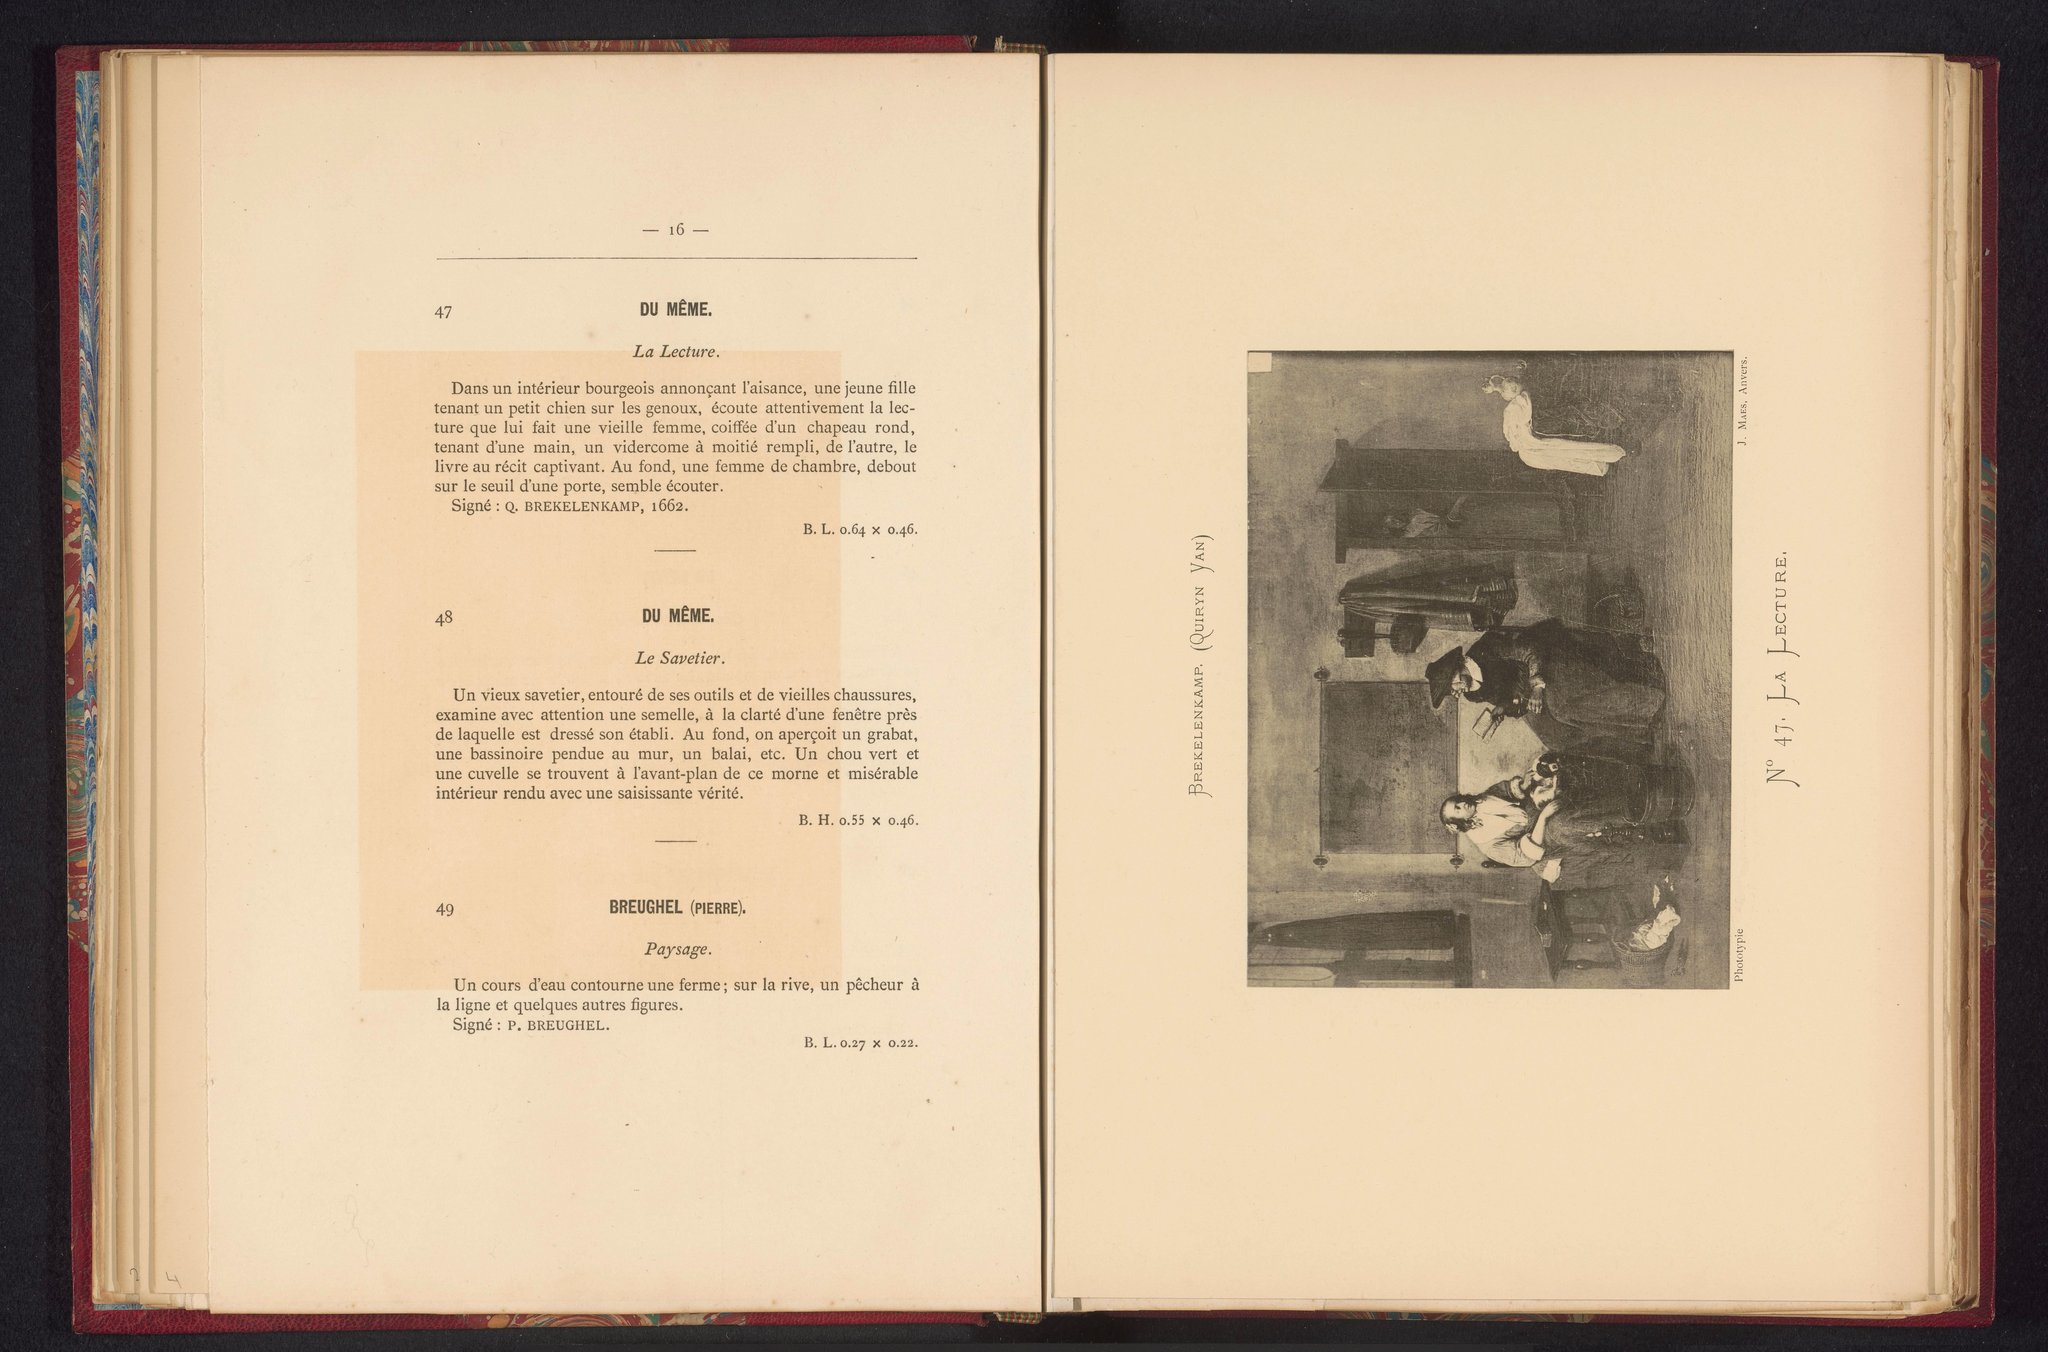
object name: photomechanical print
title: Reproductie van een schilderij van een onbekende man die een onbekende vrouw onderwijst van Quiringh Gerritsz. van Brekelenkam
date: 1878-1883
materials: paper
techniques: photograph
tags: historical persons, book, painting, drawing and the graphic arts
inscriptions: number: ‘No. 47’